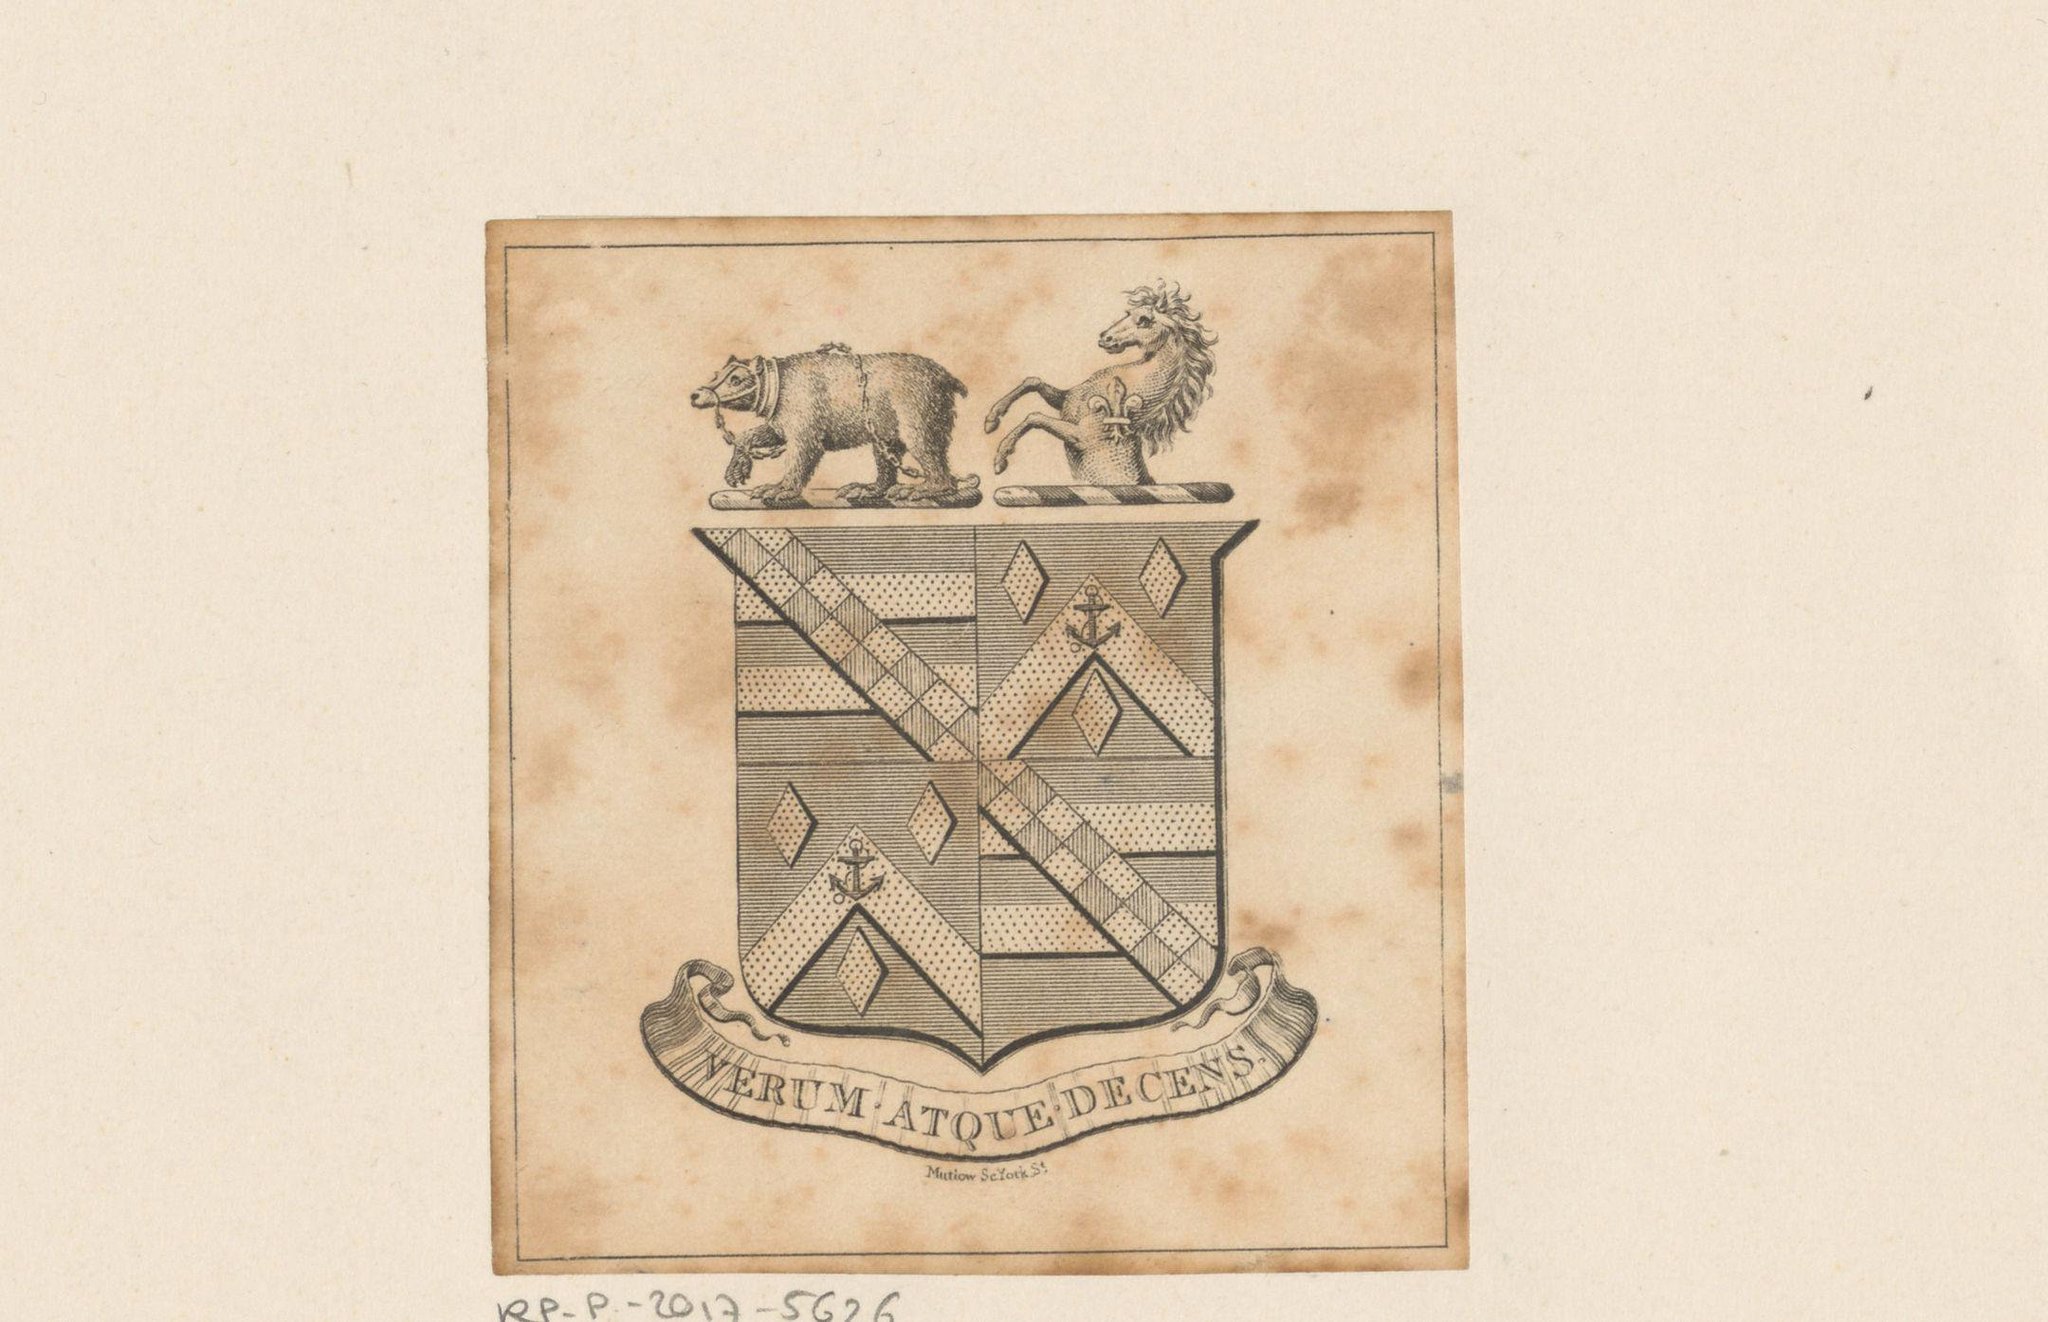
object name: bookplate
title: Verum atque decens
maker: henry mutlow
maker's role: print maker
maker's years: 1756-1826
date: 1800-1899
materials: paper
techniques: etching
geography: london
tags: beasts of prey, predatory animals: bear, horse, armorial bearing, heraldry